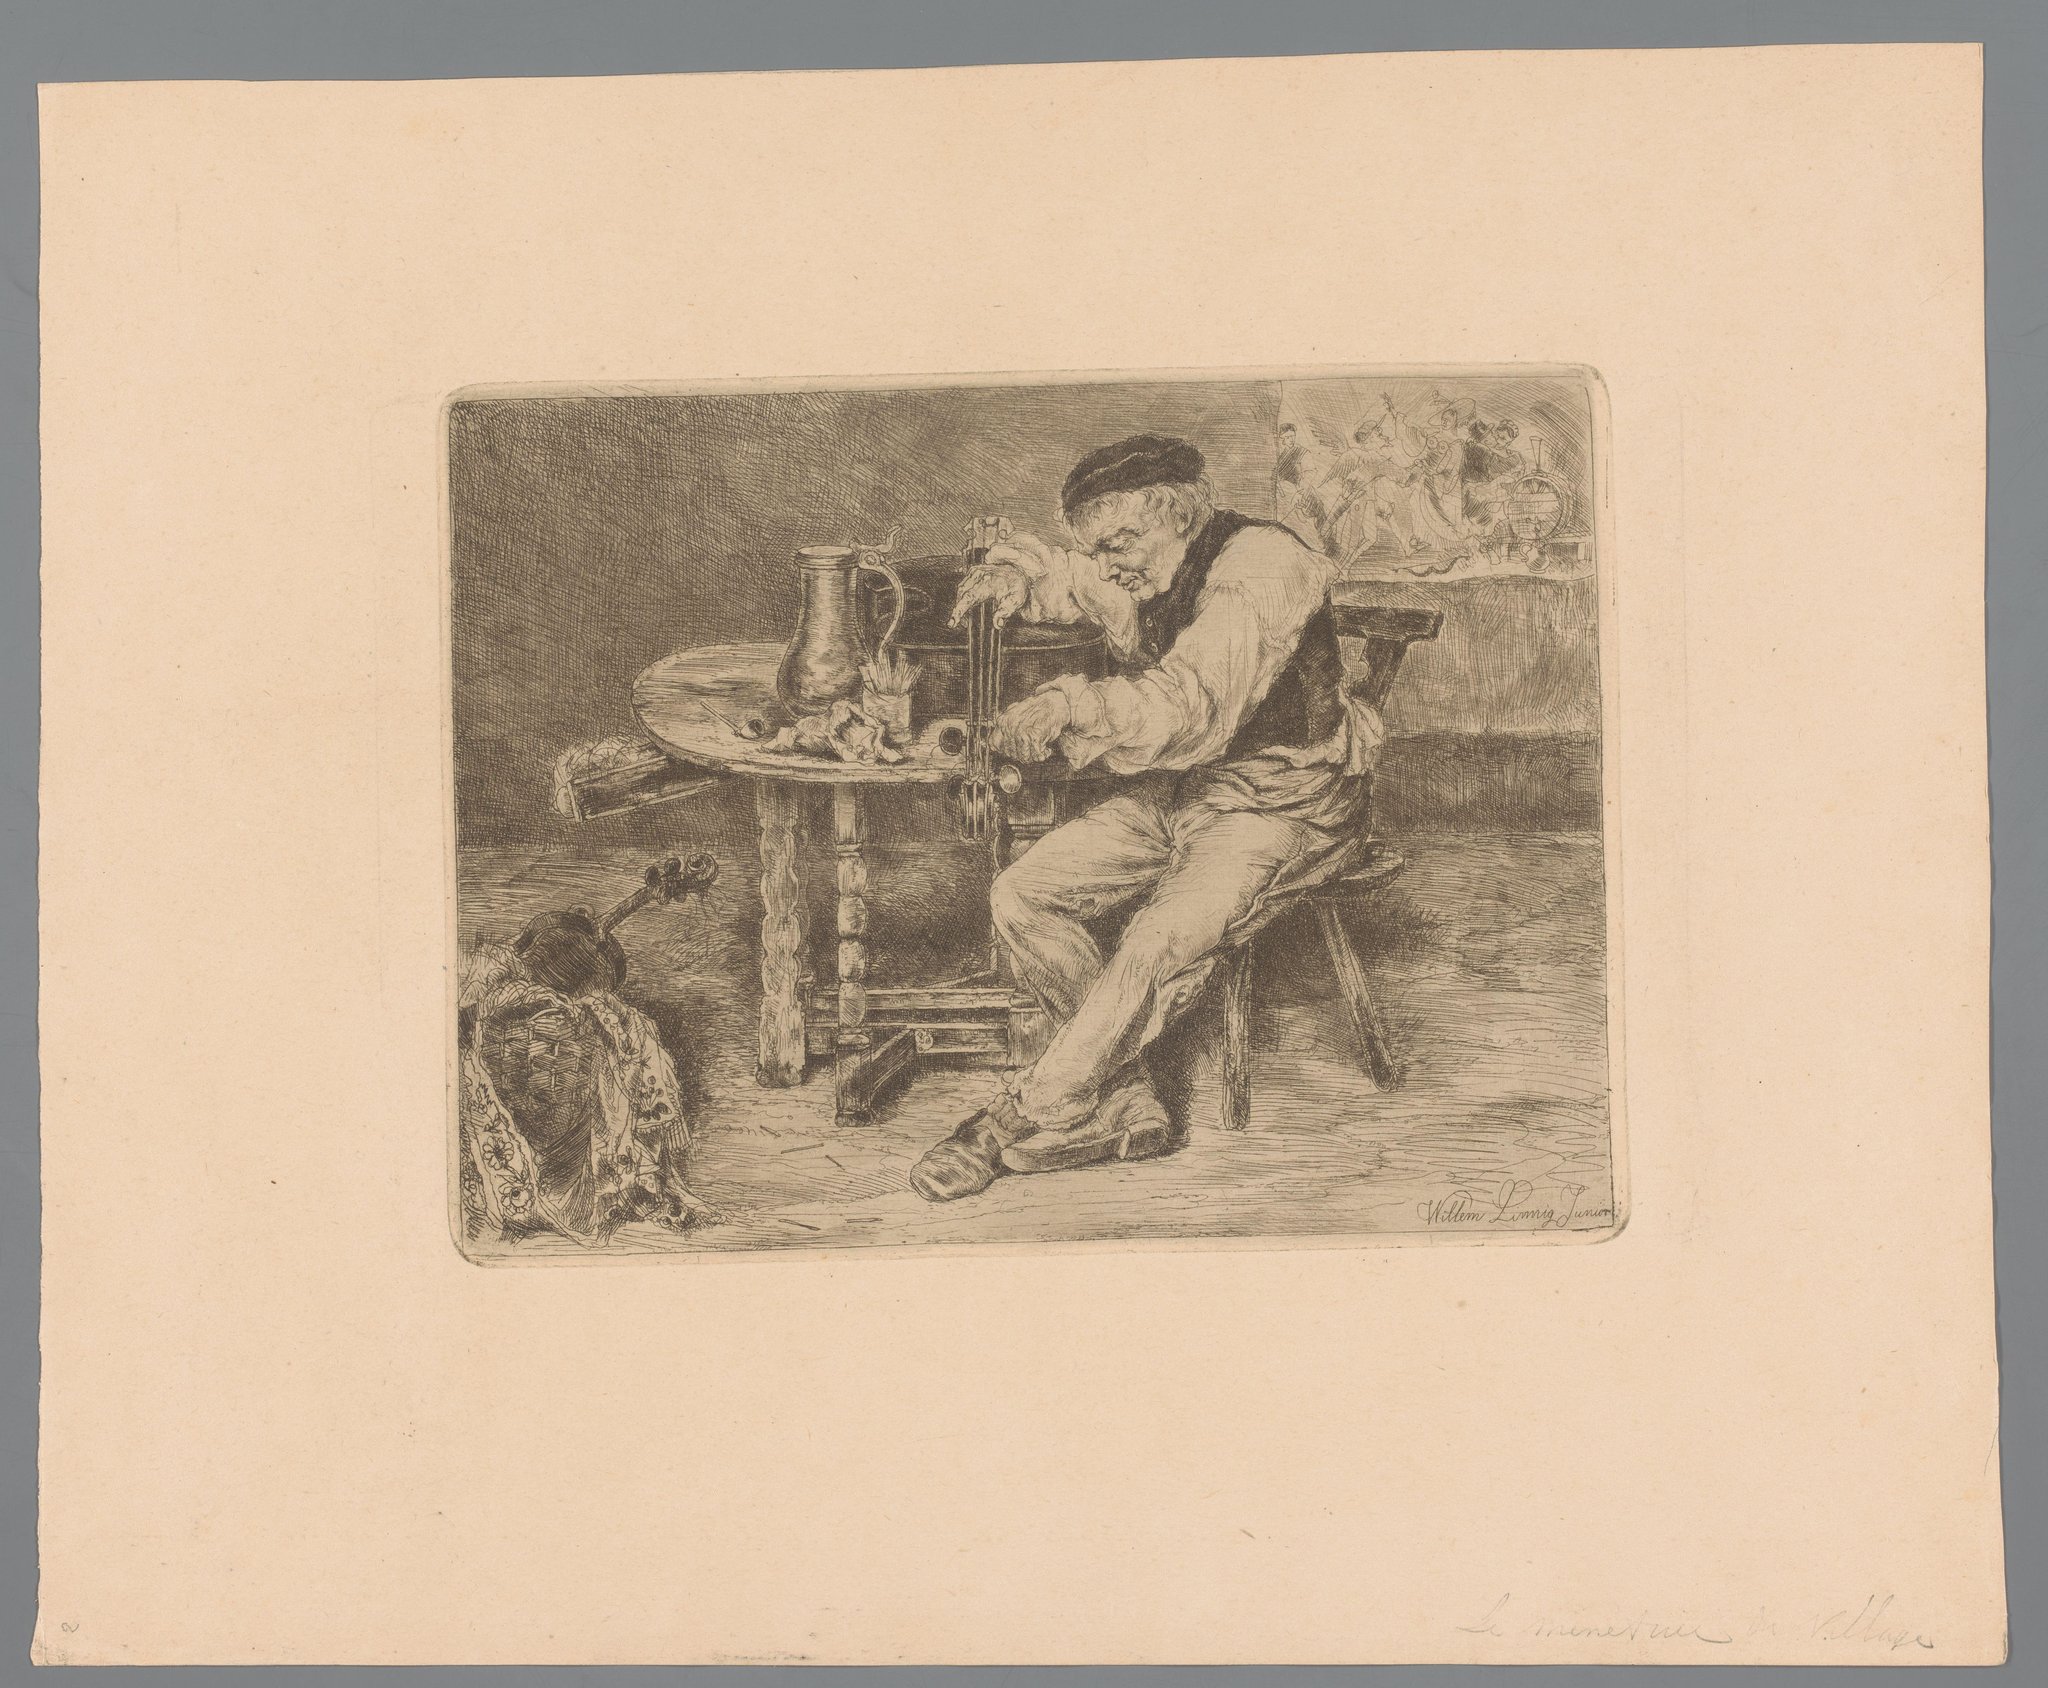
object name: print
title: Muzikant besnaart een cello voor hem op tafel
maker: willem linnig (ii)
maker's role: print maker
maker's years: 1842-1890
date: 1852-1890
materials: paper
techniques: drypoint, etching, intaglio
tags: violin, fiddle, viola, violoncello; double bass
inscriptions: collector's mark: Lugt 2228